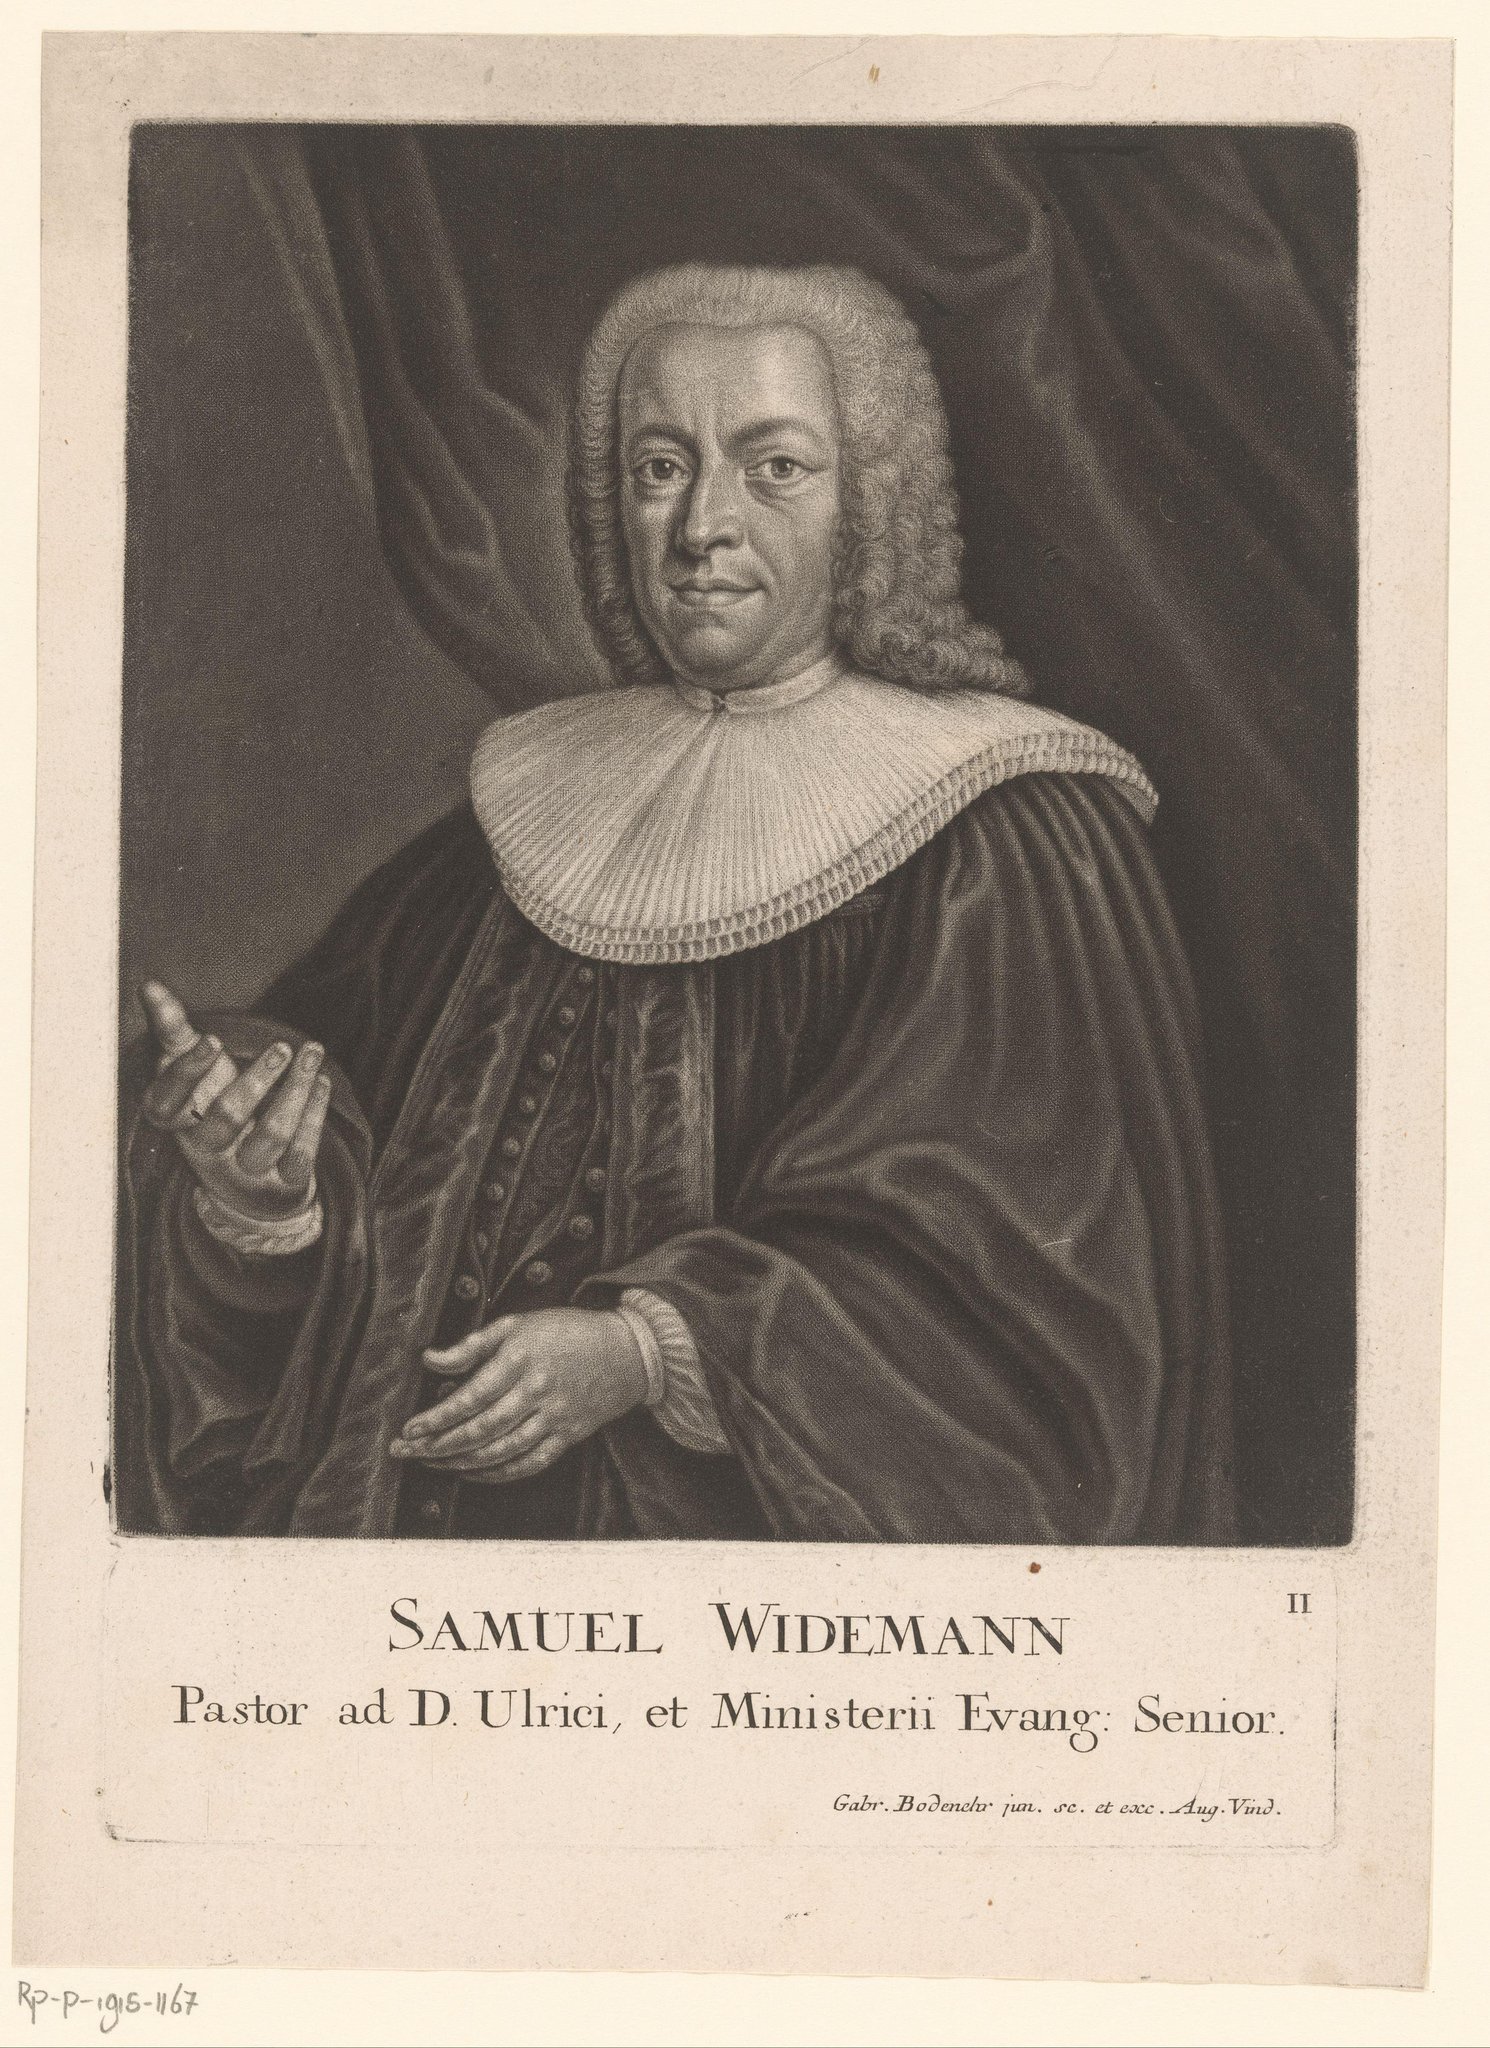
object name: print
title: Portret van Samuel Widemann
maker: gabriel bodenehr (ii)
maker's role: print maker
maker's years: 1705-1792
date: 1715-1792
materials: paper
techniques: mezzotint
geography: augsburg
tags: augsburg, theologian, historical persons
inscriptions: collector's mark: Lugt 2228